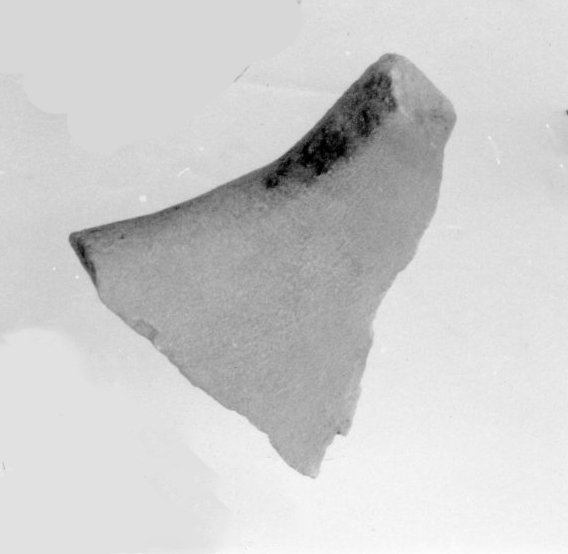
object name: canopic box, siptah, top surface, inner surface, jar lip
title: Fragment of the Top Surface of Siptah's Canopic Chest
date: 1194-1188 BCE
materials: stone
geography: egypt